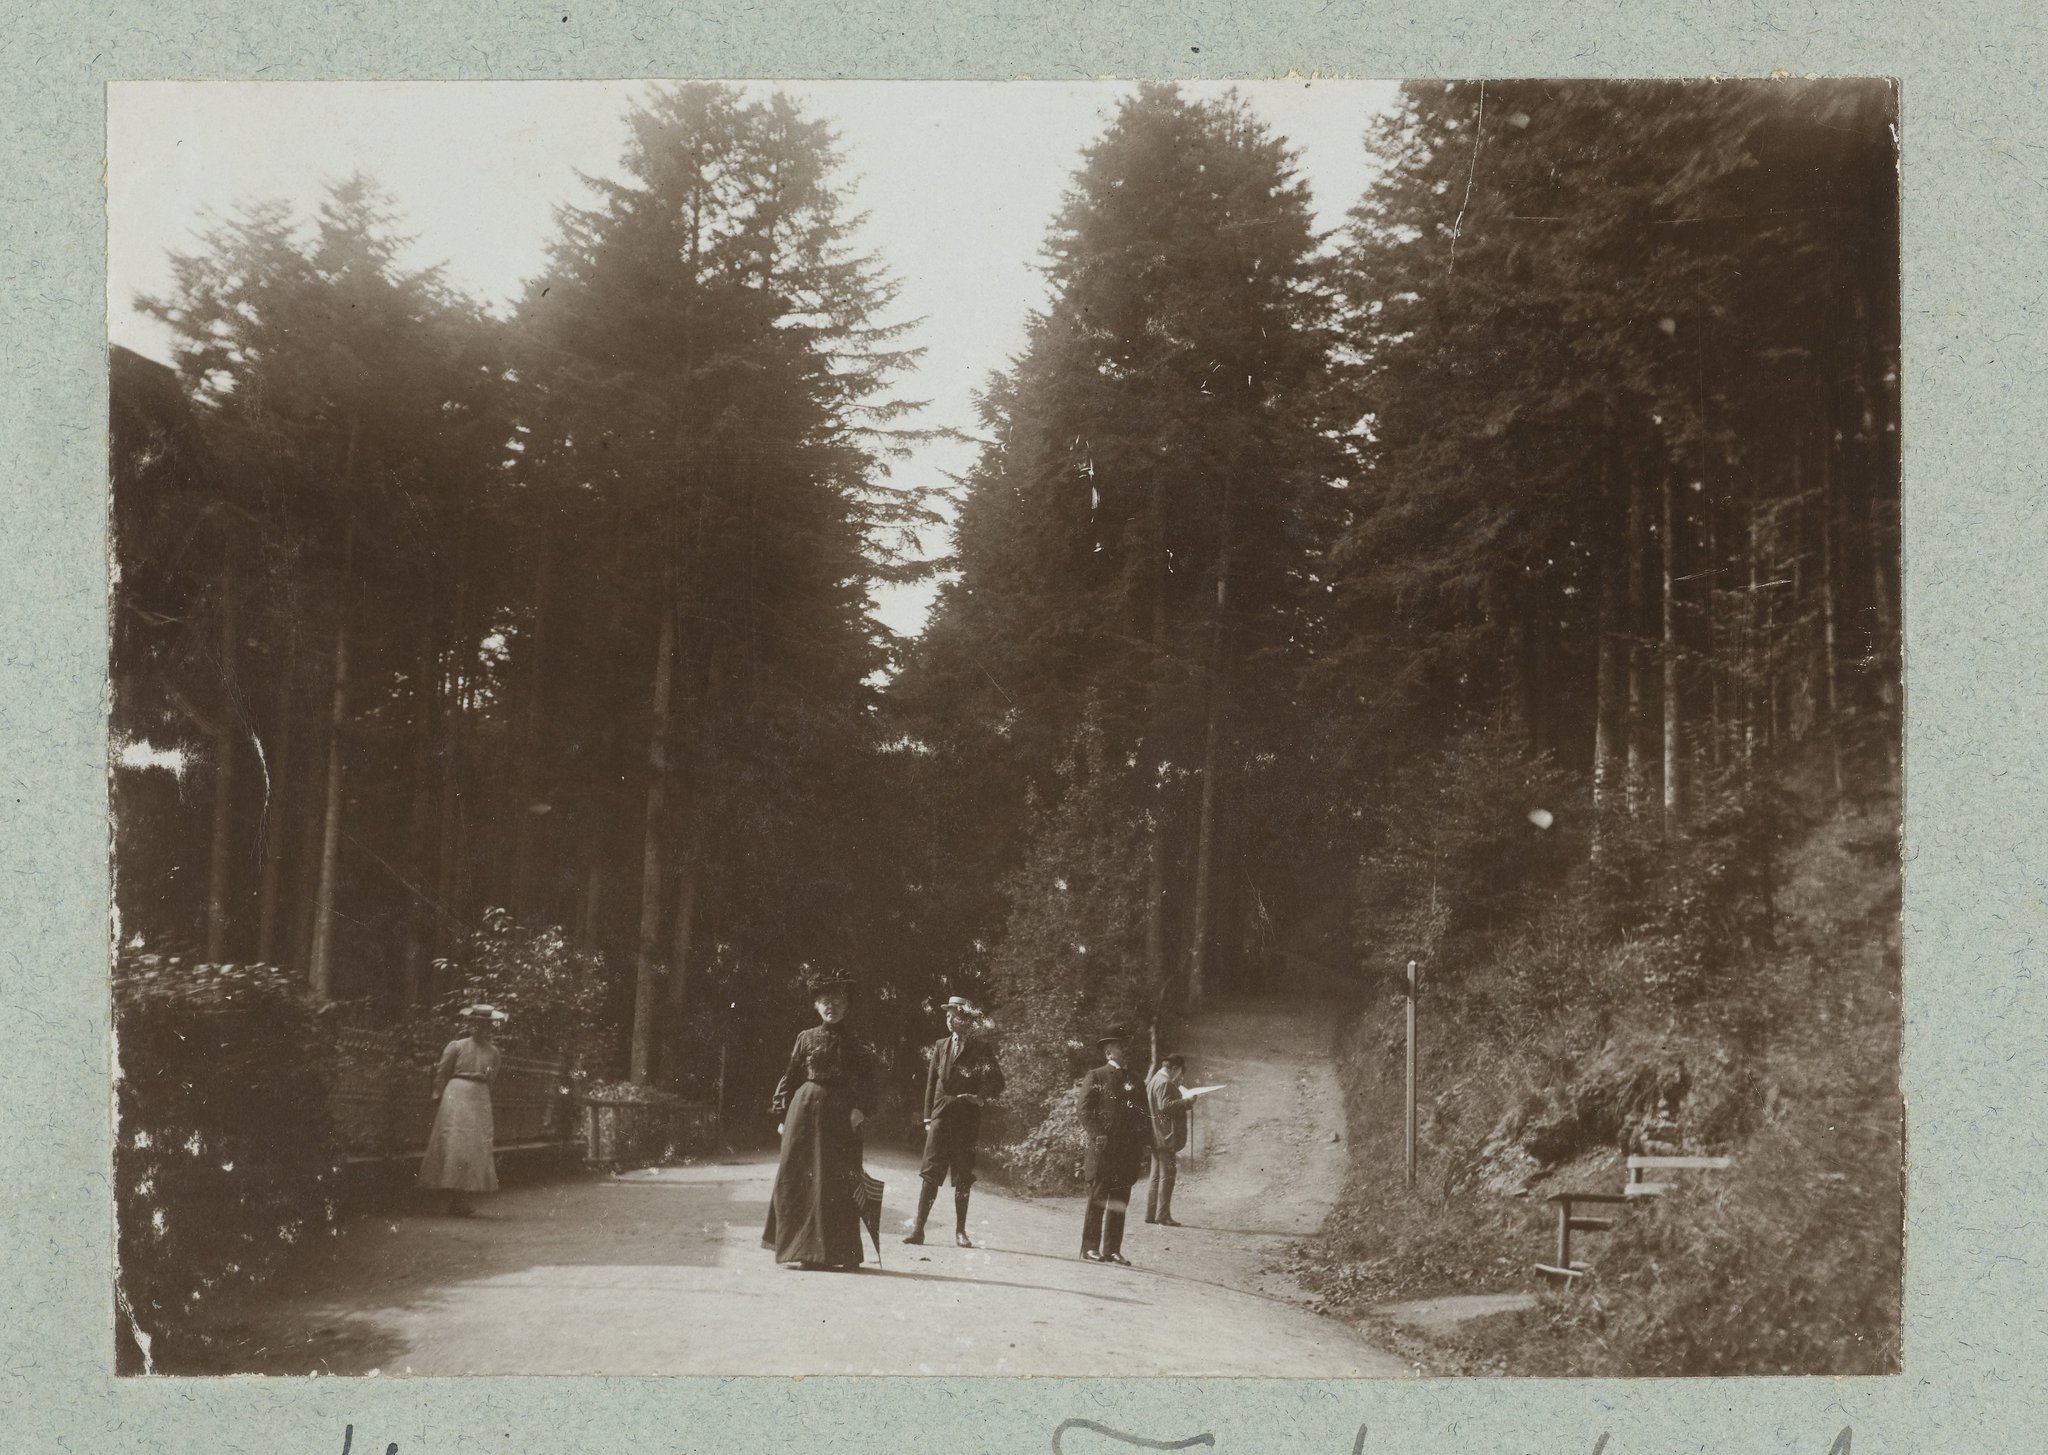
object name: photograph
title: Photographieën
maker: frits freerks fontein fz.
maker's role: fotograaf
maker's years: 1882-1928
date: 1903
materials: cardboard, paper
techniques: gelatin silver print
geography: germany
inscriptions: caption: ‘Thüringen Herzugsweg Friedrichroda 1903’